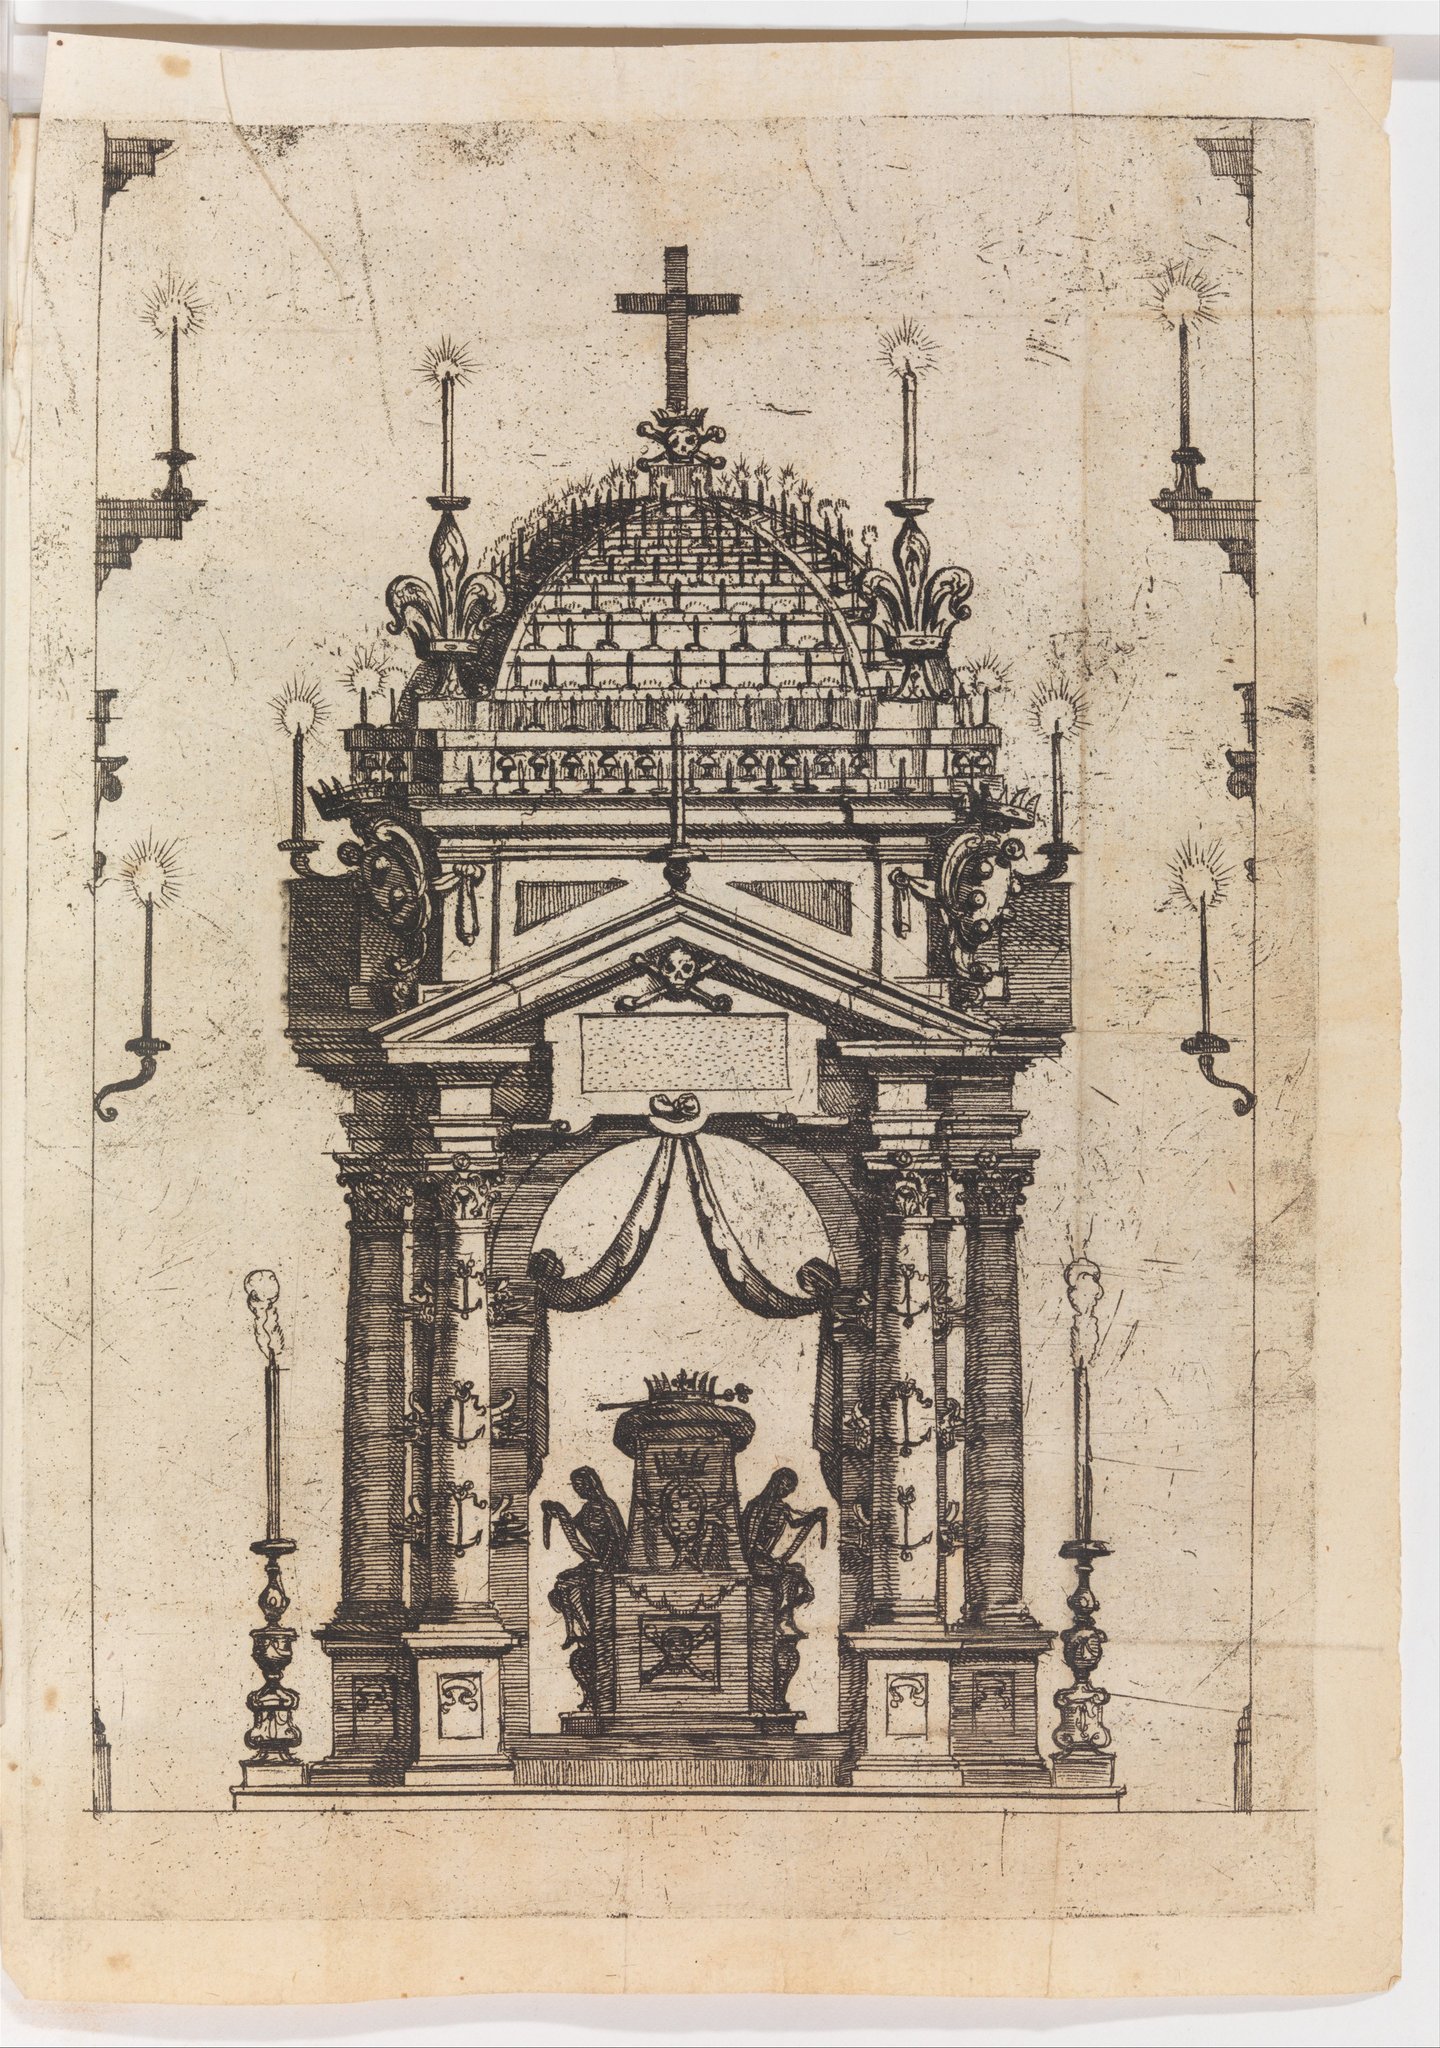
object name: print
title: Catafulque for Fernando I, Duke of Tuscany, from Descritione dell'Esequie fatte in Roma dalla Natione Fiorentina al Serenissimo Ferdinando III Gran Duca di Toscana Il dì 22 di Giugno 1609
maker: giacomo mascardi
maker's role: publisher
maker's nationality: italian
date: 1609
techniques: etching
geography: italy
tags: architecture,cross